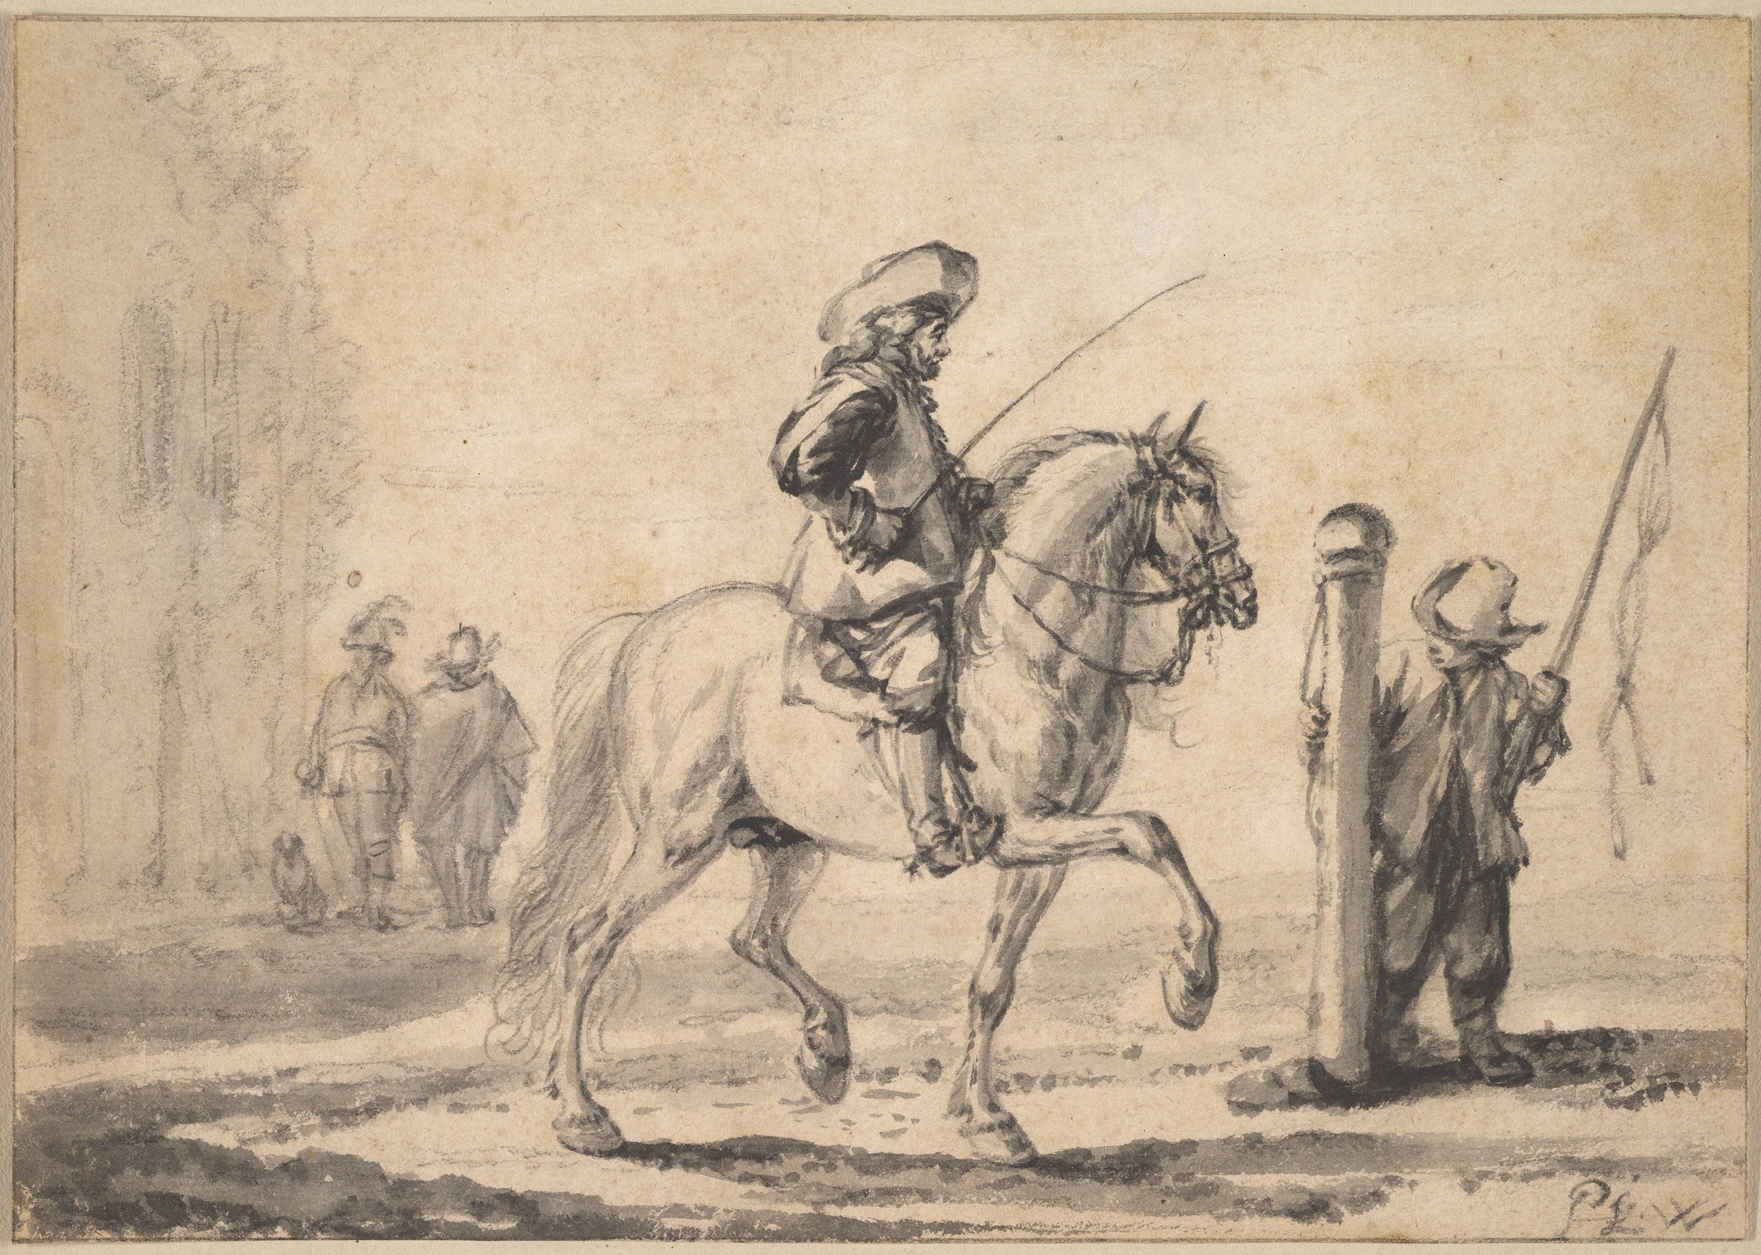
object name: drawing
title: A Mounted Grey Horse Being Schooled in Piaffe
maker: philips wouwerman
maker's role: artist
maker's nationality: dutch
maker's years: 1619-1668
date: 1646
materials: chalk, graphite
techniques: brush, wash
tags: men,horses